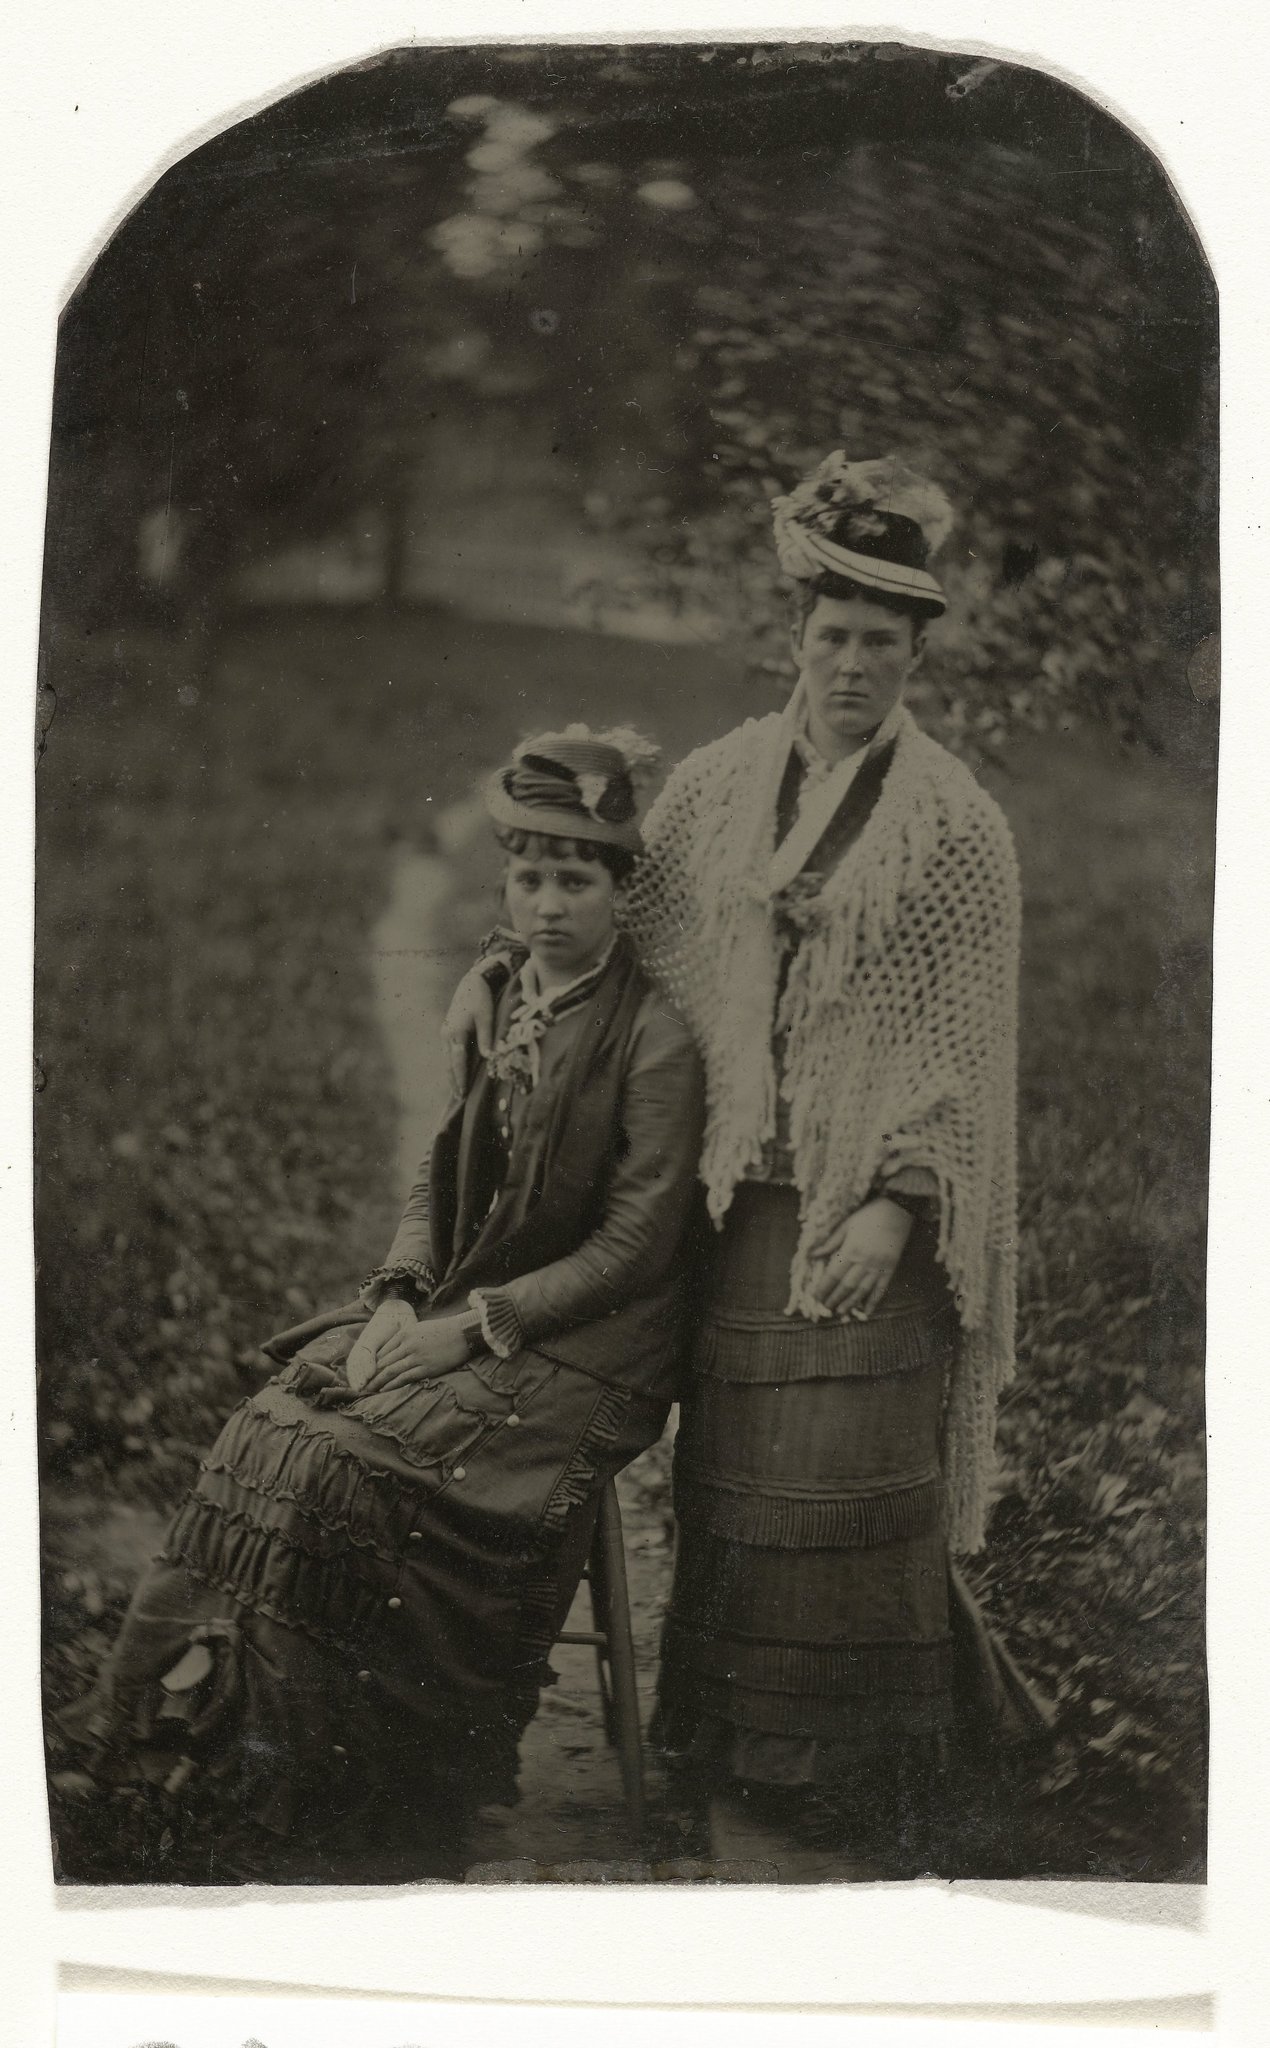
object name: photograph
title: Two women in a landscape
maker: Anonymous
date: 1890-1910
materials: metal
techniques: ferrotyping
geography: united states